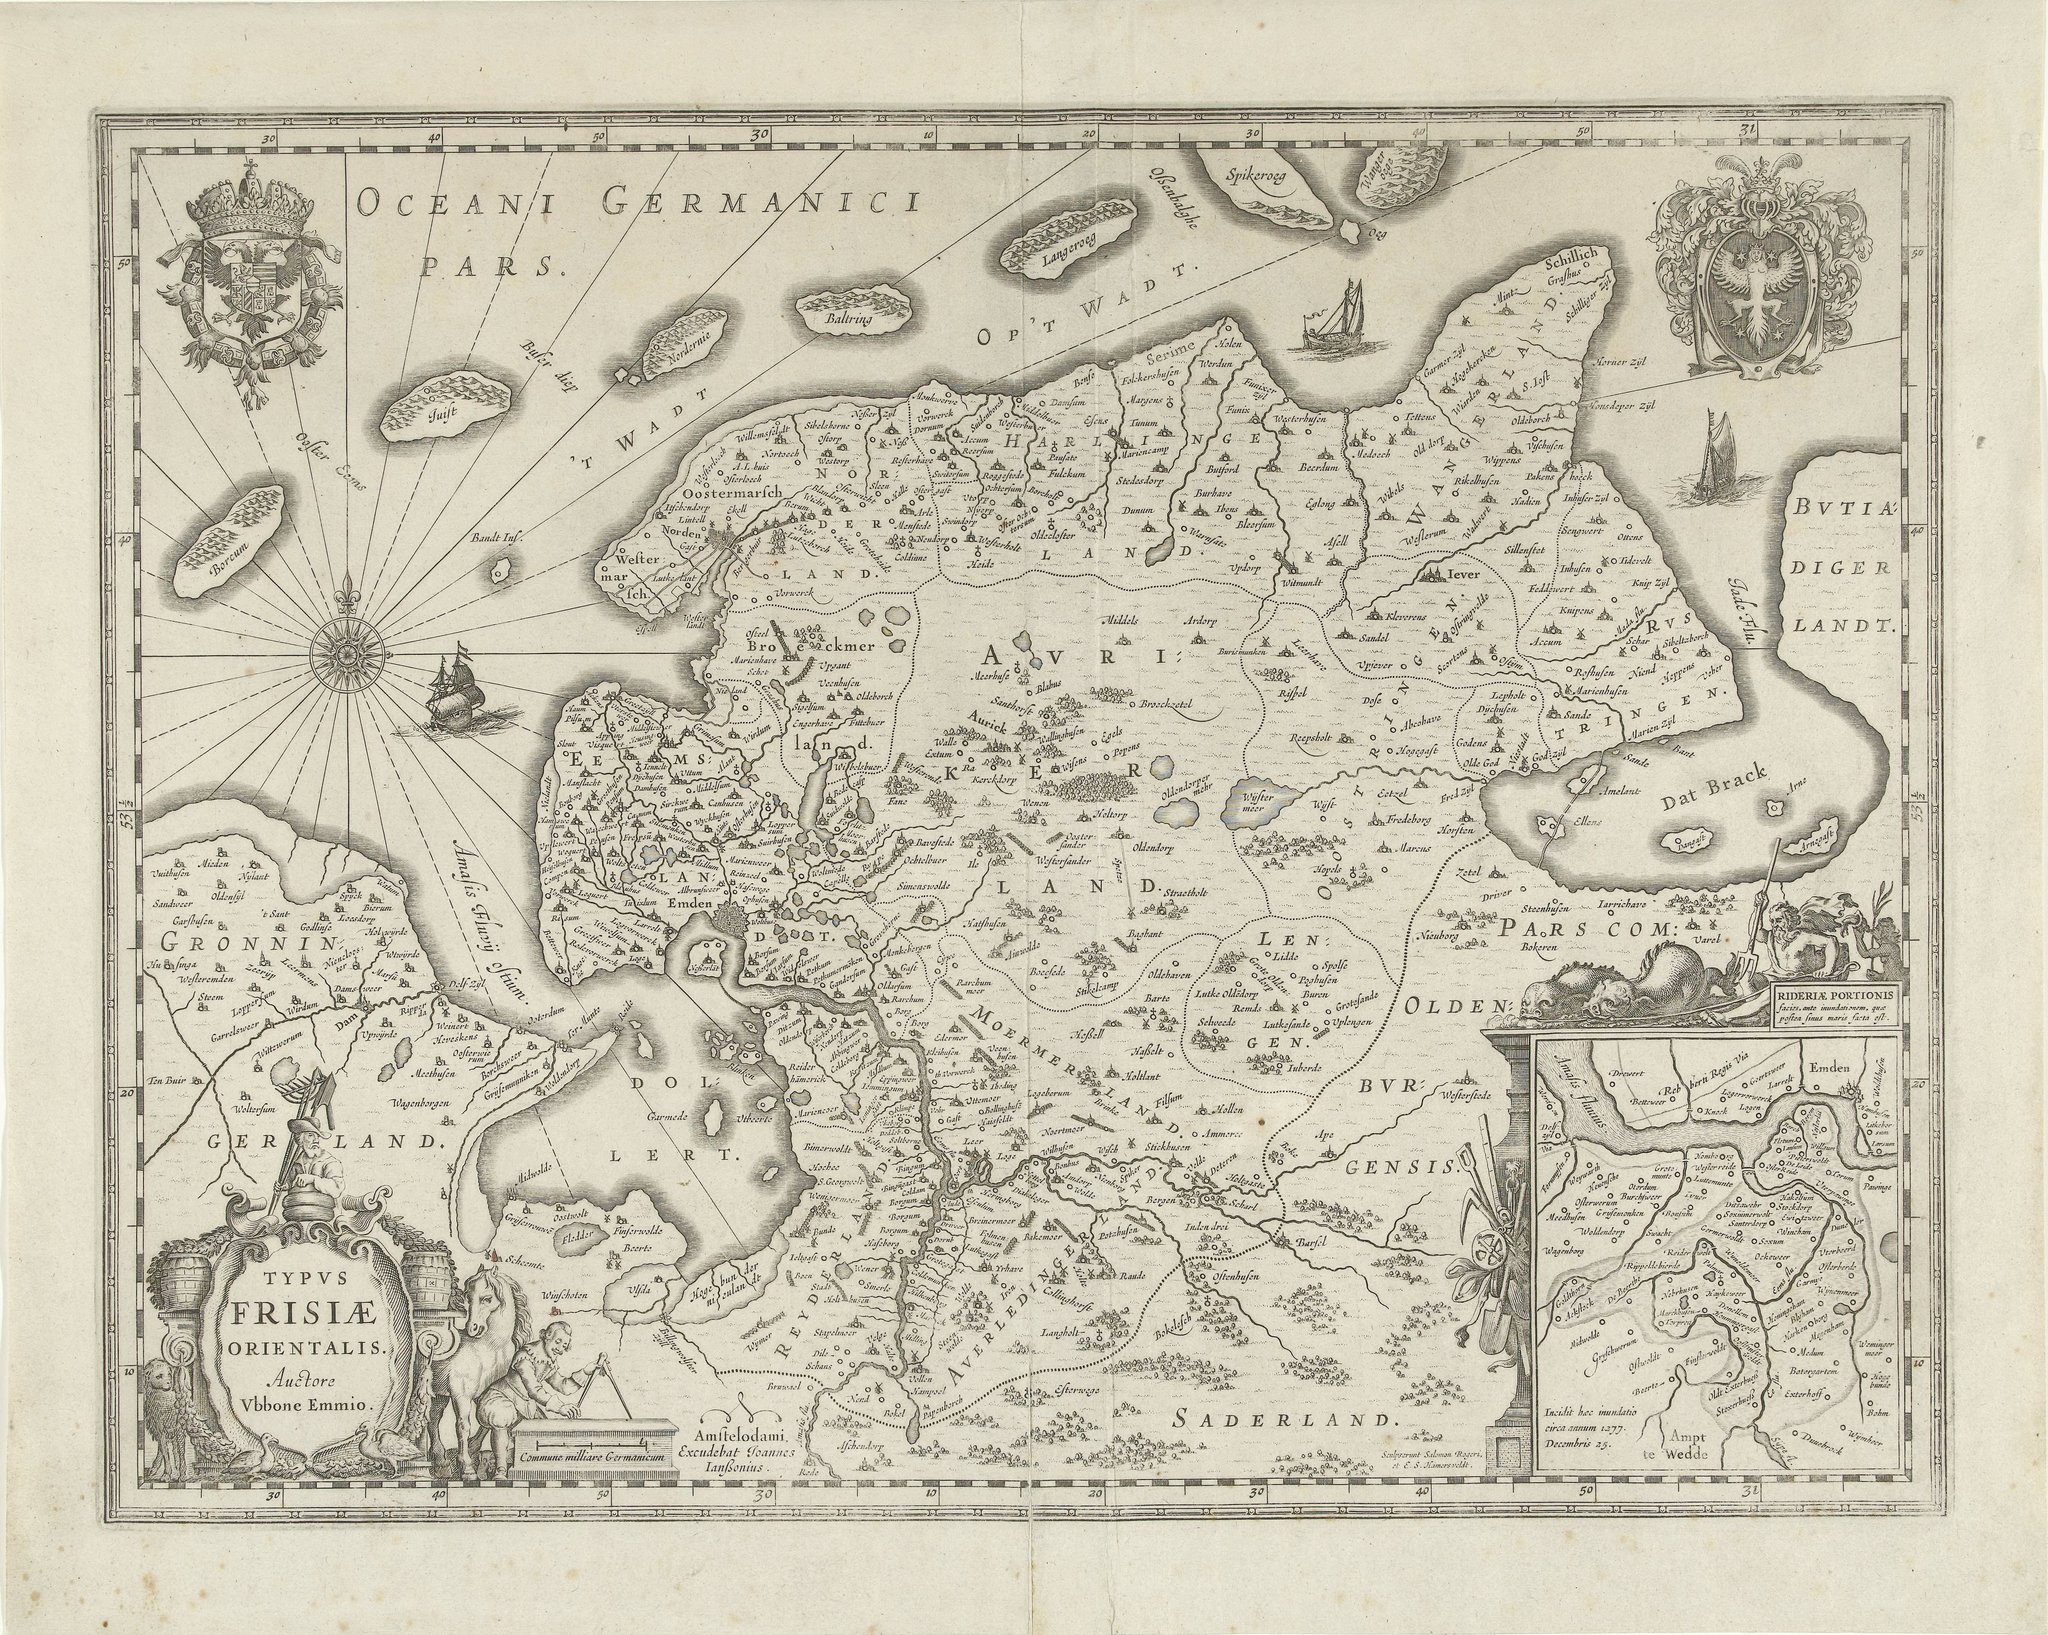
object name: map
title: Kaart van Oost-Friesland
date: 1618-1665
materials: paper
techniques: engraving, etching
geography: amsterdam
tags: maps of separate countries or regions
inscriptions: collector's mark: Lugt 2166, collector's mark: Lugt 2760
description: Kaart van Oost-Friesland met linksboven het keizerlijk wapen met Gulden Vlies en rechtsboven een ander wapen. Linksonder een gedecoreerde cartouche met de titel en rechtsonder een uitsnede. Alle opschriften in het Latijn.